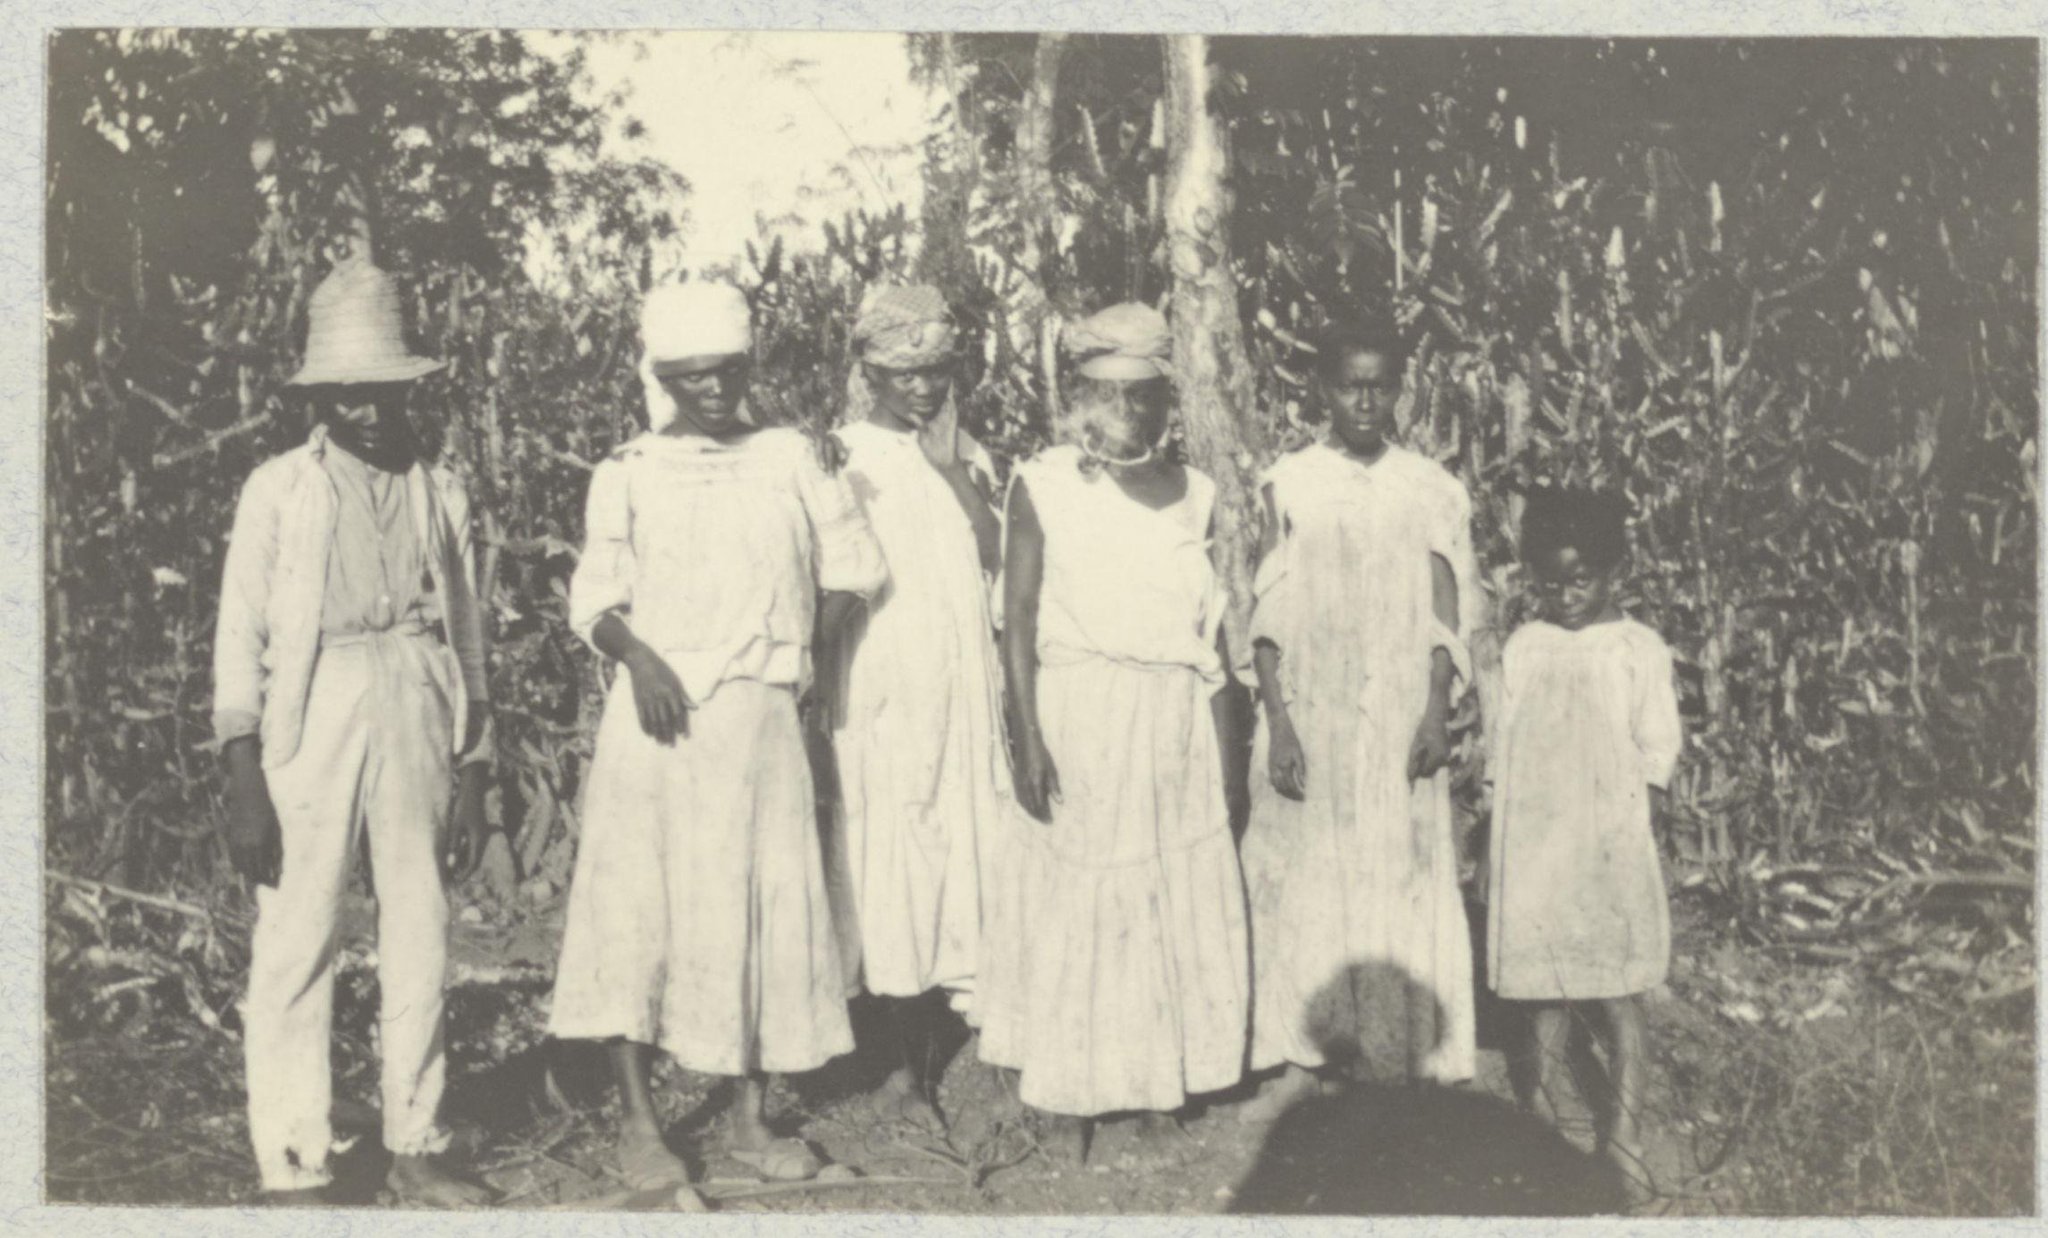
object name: photograph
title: Familie te Petit Goâve op Haïti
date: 1911-1912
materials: photographic support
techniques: photography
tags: parents with their children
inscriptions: inscription: ‘Negerfamilie te Petit Goave / Dec. 1911.’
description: Portret van een lokale familie, in Petit Goâve op Haïti, december 1911. Onderdeel van het fotoalbum van de familie Boom-Gonggrijp in Suriname en Curaçao.